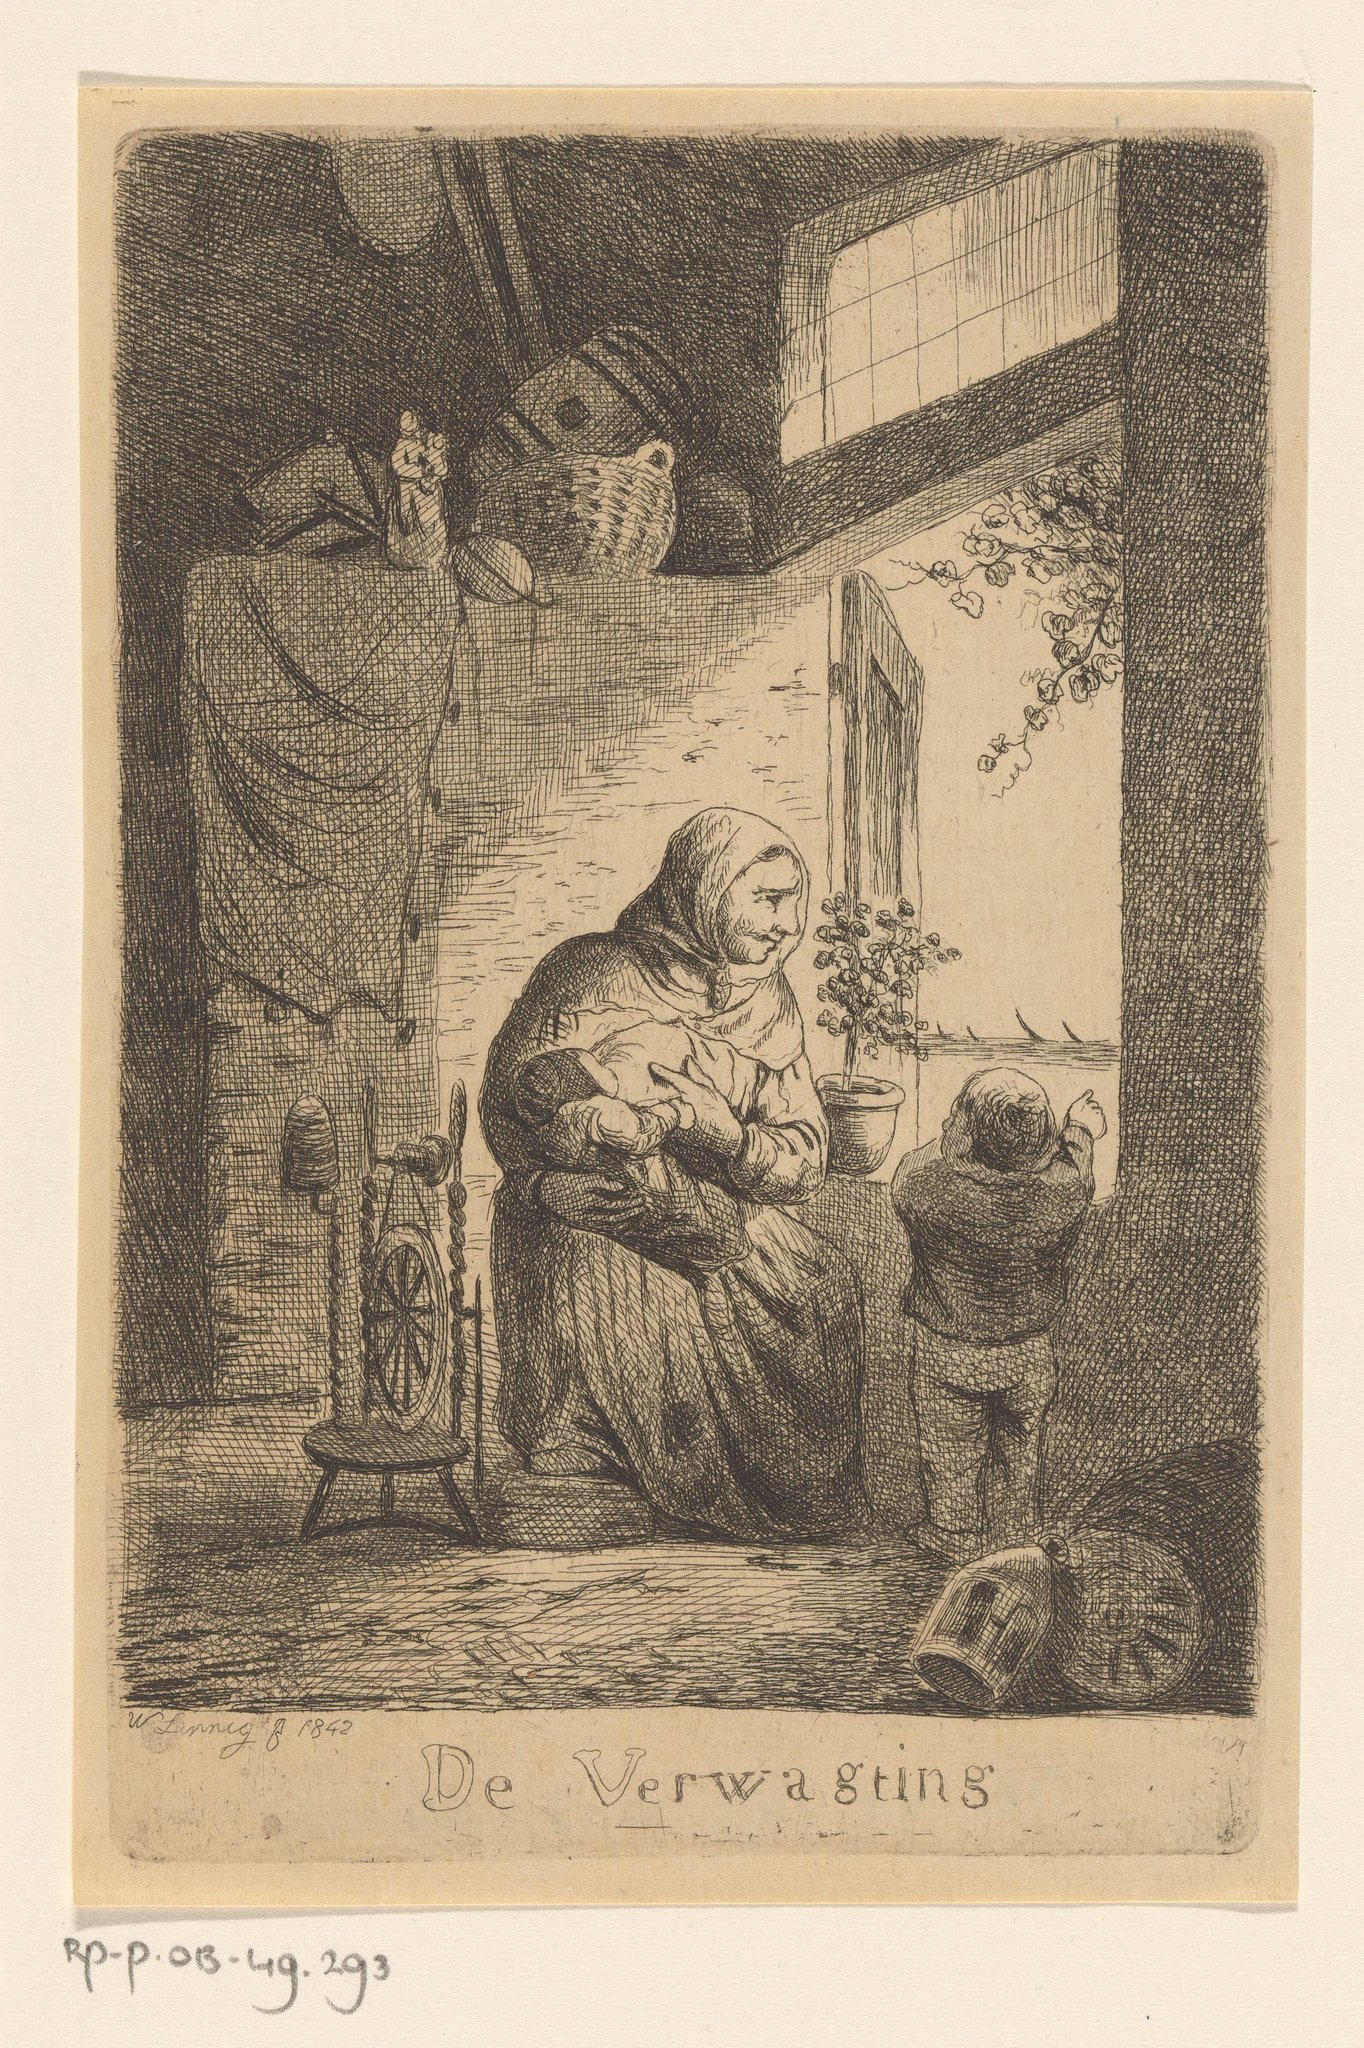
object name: print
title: Moeder voedt haar baby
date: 1842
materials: paper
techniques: etching, intaglio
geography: antwerp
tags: feeding a baby, one lover waiting for the other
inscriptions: collector's mark: Lugt 2228